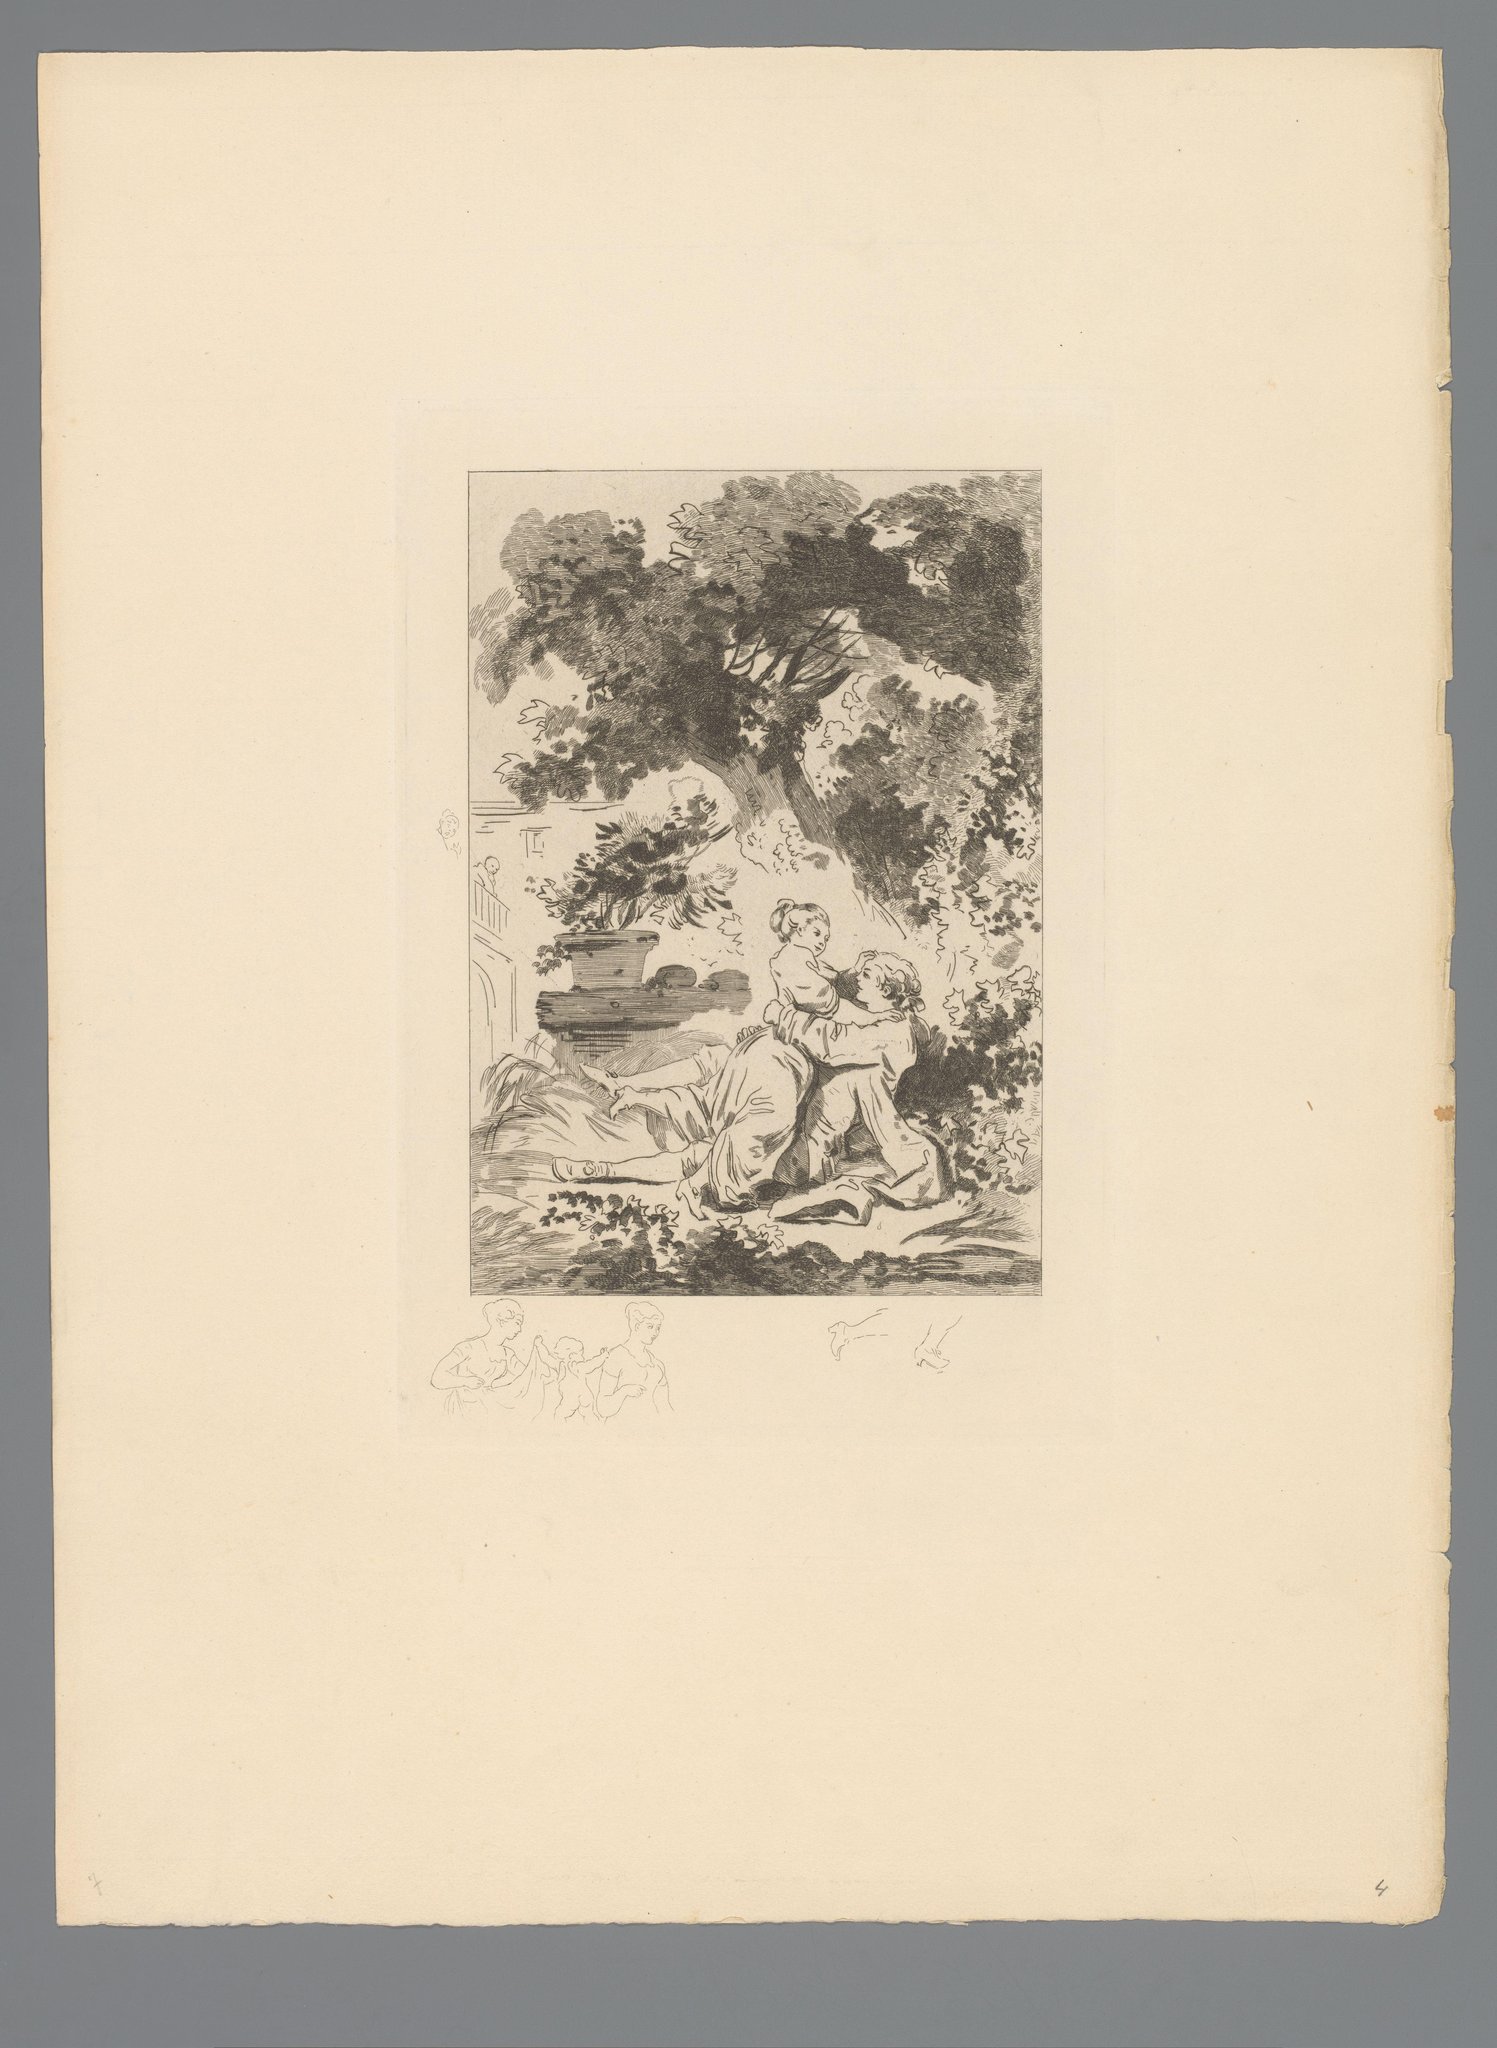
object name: reproduction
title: Figuren uit de verhalen van La Fontaine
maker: Anonymous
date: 1880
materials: paper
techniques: photoaquatint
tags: fables of lafontaine : use 85(...), courtesy, manners; etiquette, maid ~ house personnel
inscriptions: collector's mark: Lugt 2228, collector's mark:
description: Martial Potémont maakte etsen naar de tekeningen van Fragonard, die zich bevonden in een manuscript in de collectie van de verzamelaar Eugène Paillet. Rouquette bood hem aan de tekeningen zo exact mogelijk in prent te laten brengen door Martial Potémont: dit resulteerde in een serie van 57 etsen. Vervolgens werden deze gereproduceerd door middel van heliogravure. Deze omslag betreft een editie voor de letter, "Eau forte pure", de 1e staat van 3 waar men uit kon kiezen bij deze serie.